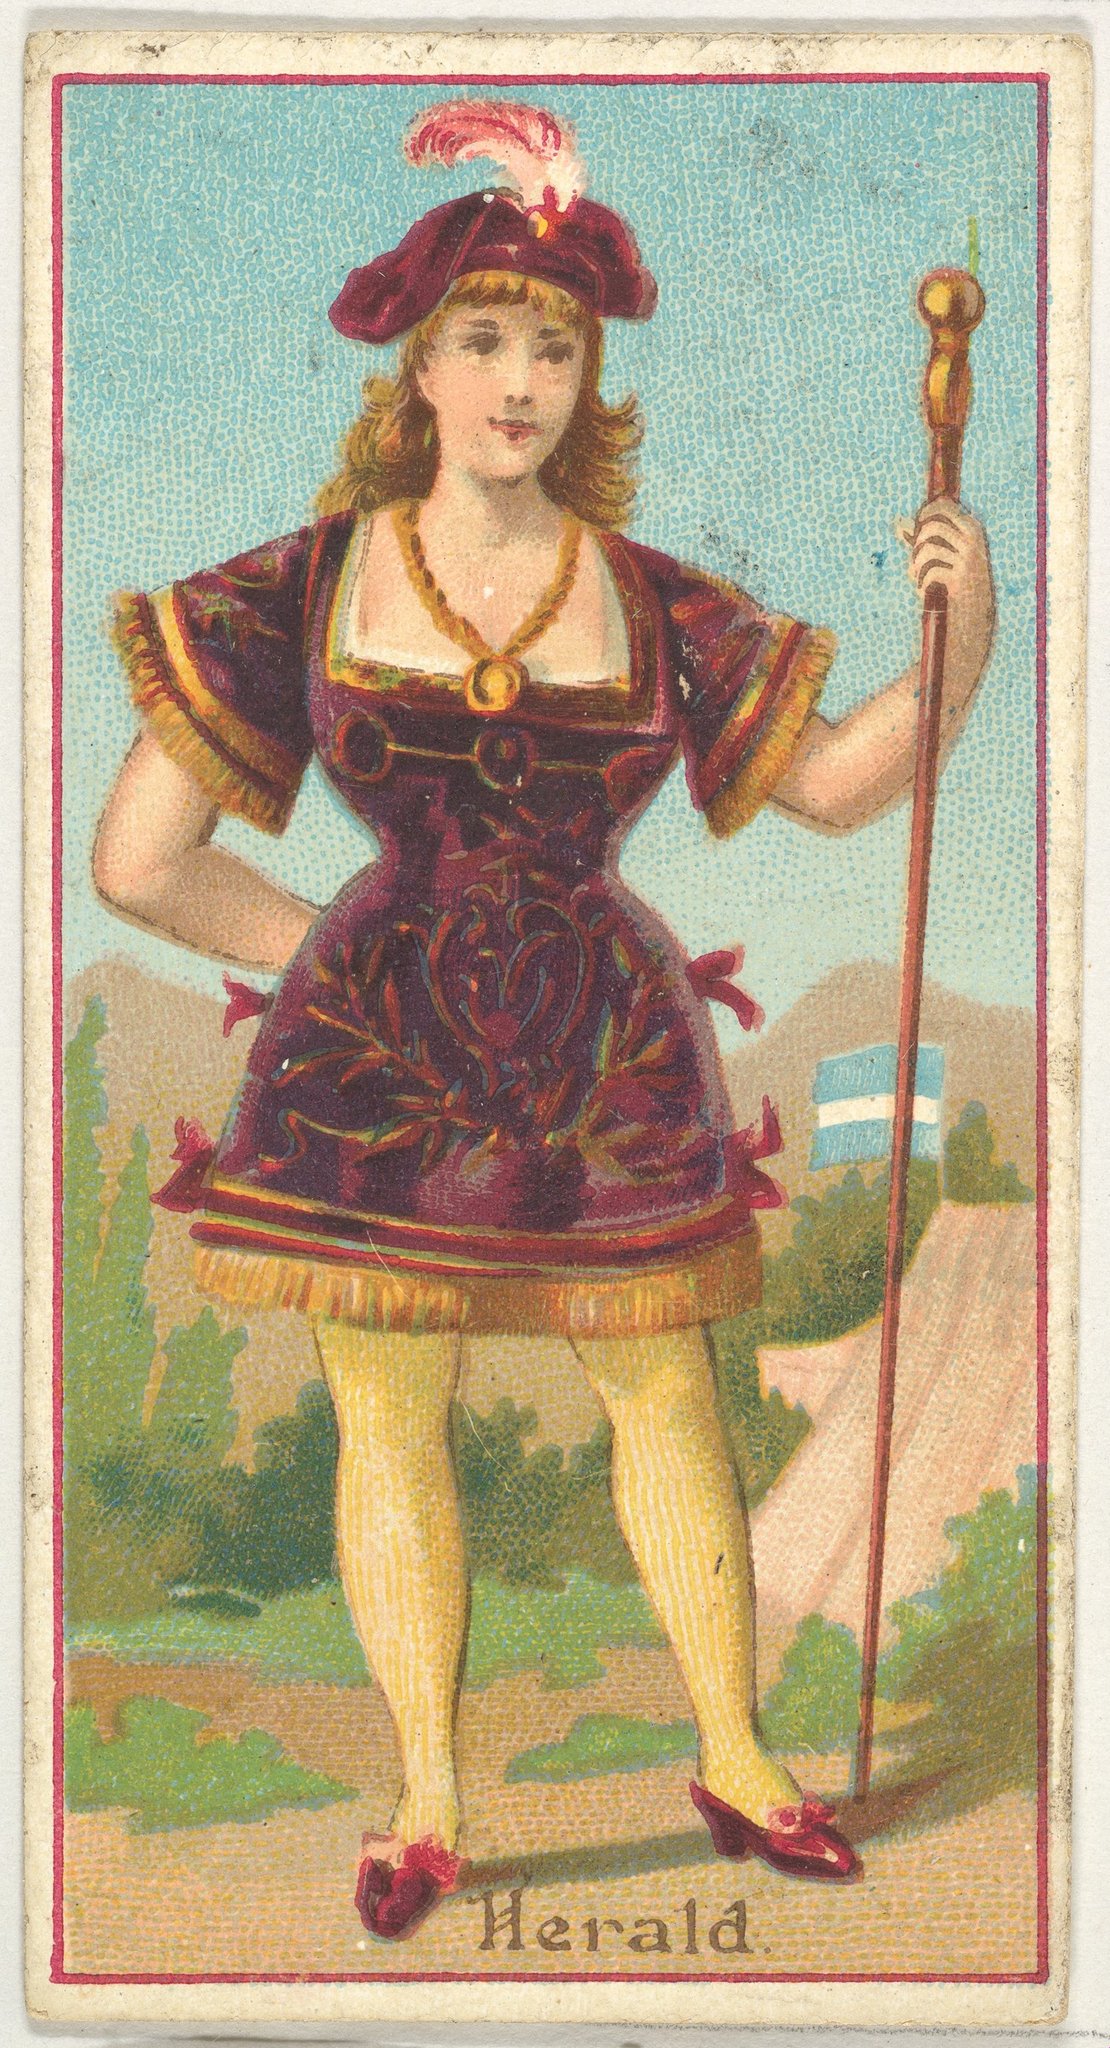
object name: print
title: Herald, from the Occupations of Women series (N502) for Frishmuth's Tobacco Company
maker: frishmuth's tobacco company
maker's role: publisher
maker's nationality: american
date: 1889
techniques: color lithograph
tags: women